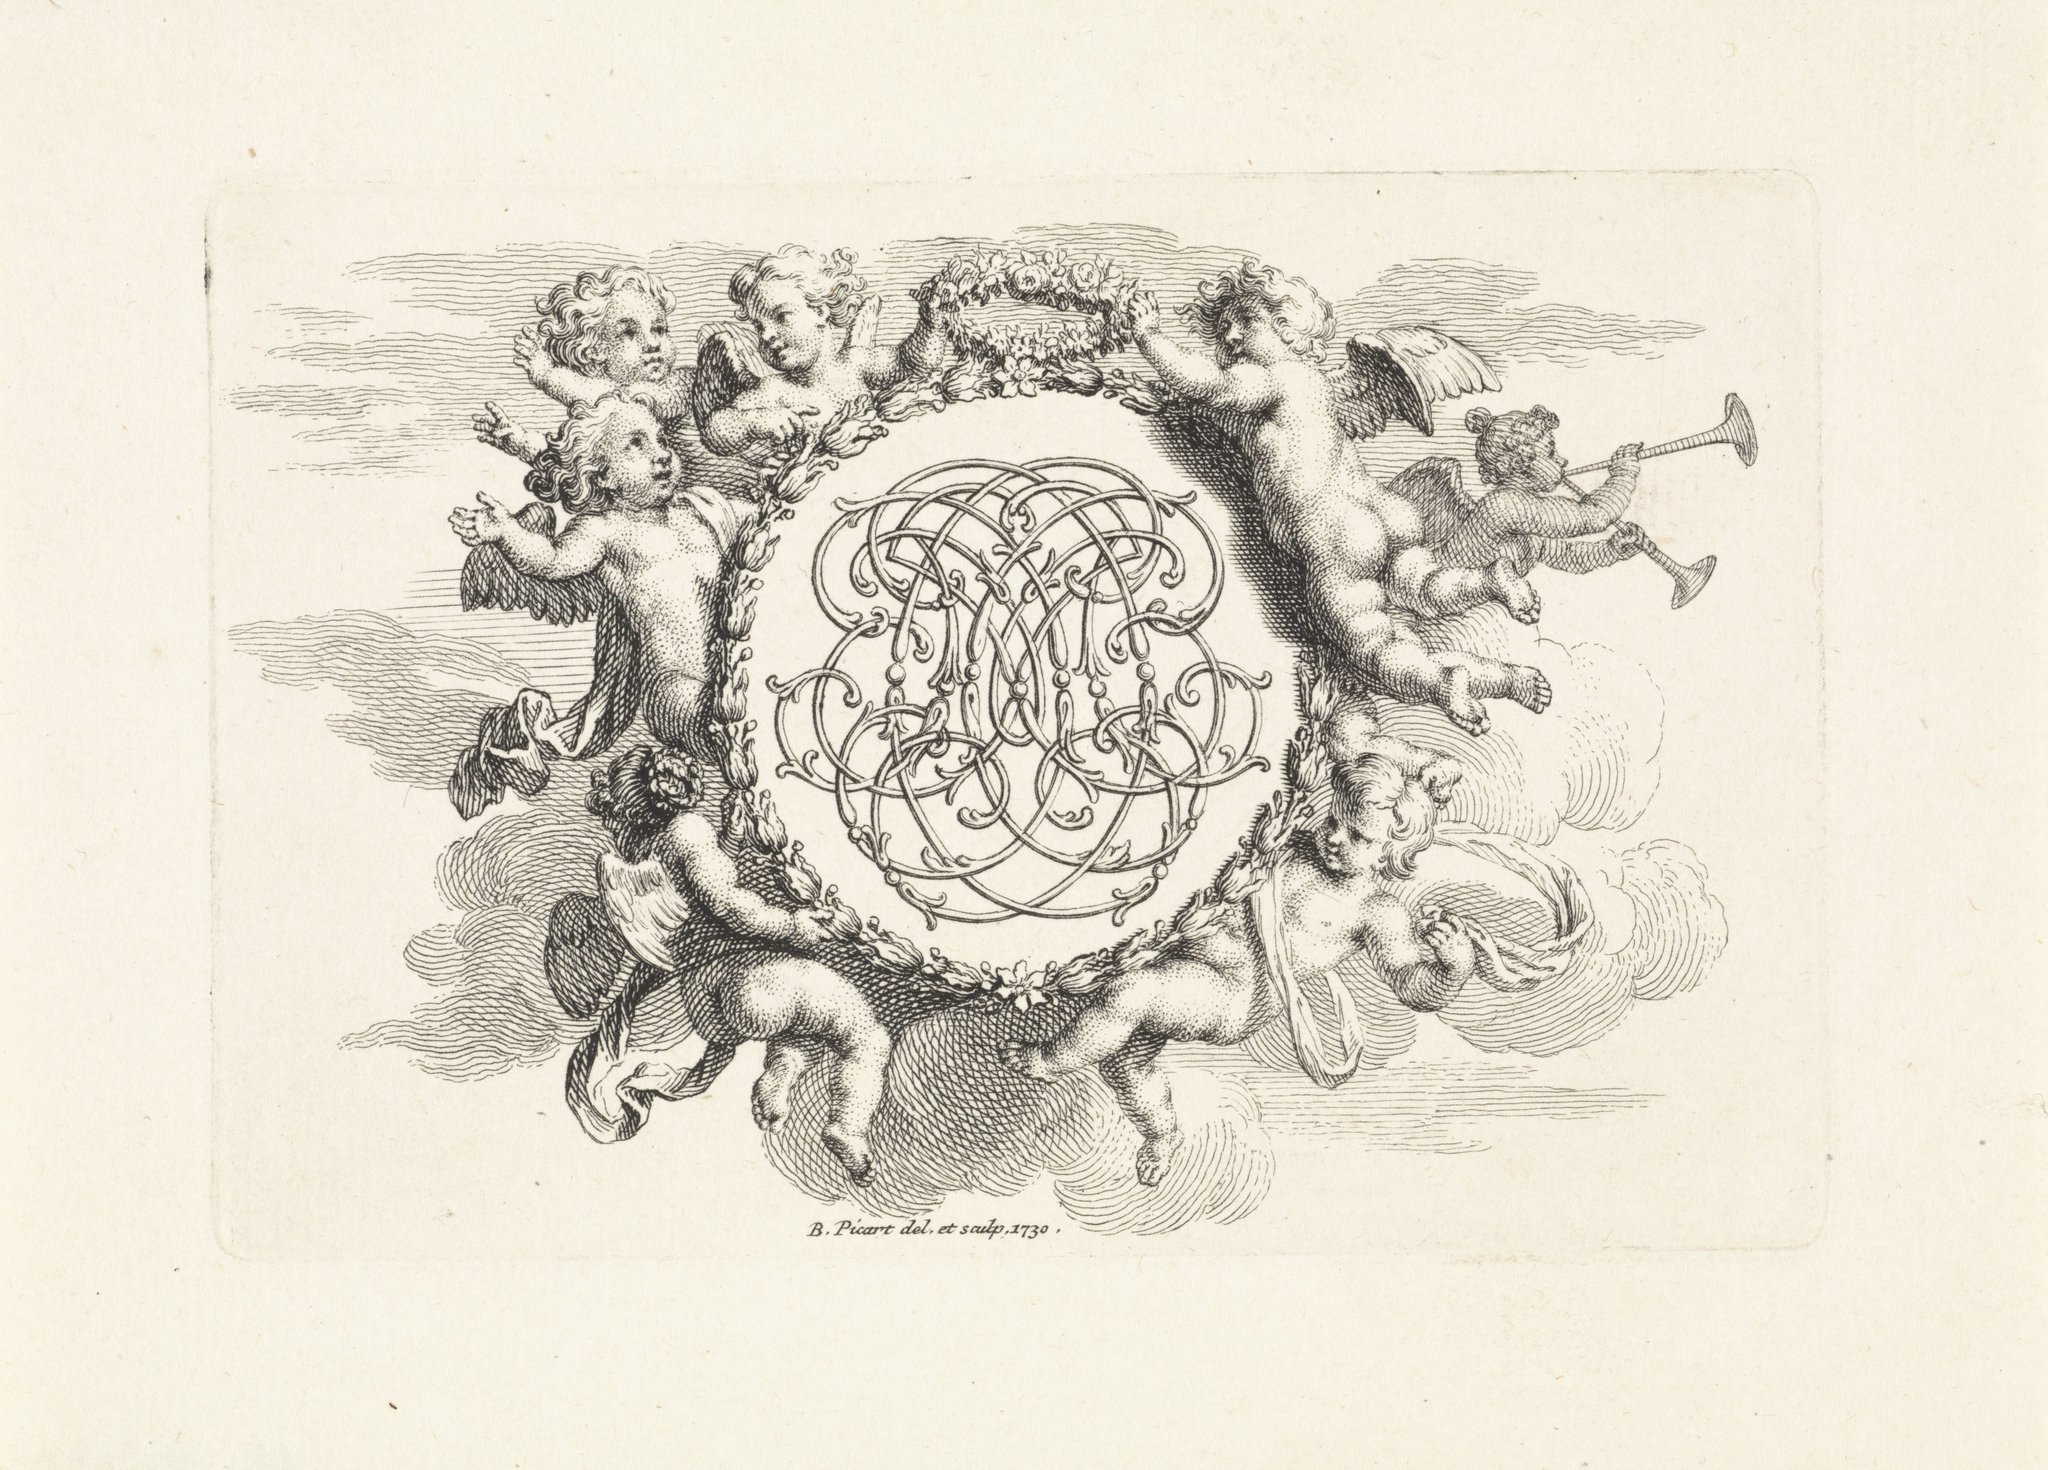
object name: book illustration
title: Medaillon met initialen gedragen door putti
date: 1730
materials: paper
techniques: engraving, etching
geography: amsterdam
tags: fame; 'fama', 'fama buona', 'fama chiara' (ripa), cupids: 'amores', 'amoretti', 'putti'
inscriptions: collector's mark: Lugt 2228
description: Prent gebruikt in: Larrey, Isaac de. Geschiedenis van Engelandt, Schotlandt en Ierlandt. 5 dln. Amsterdam: Johannes Covens en Cornelis Mortier, 1728-1730, dl. 4.